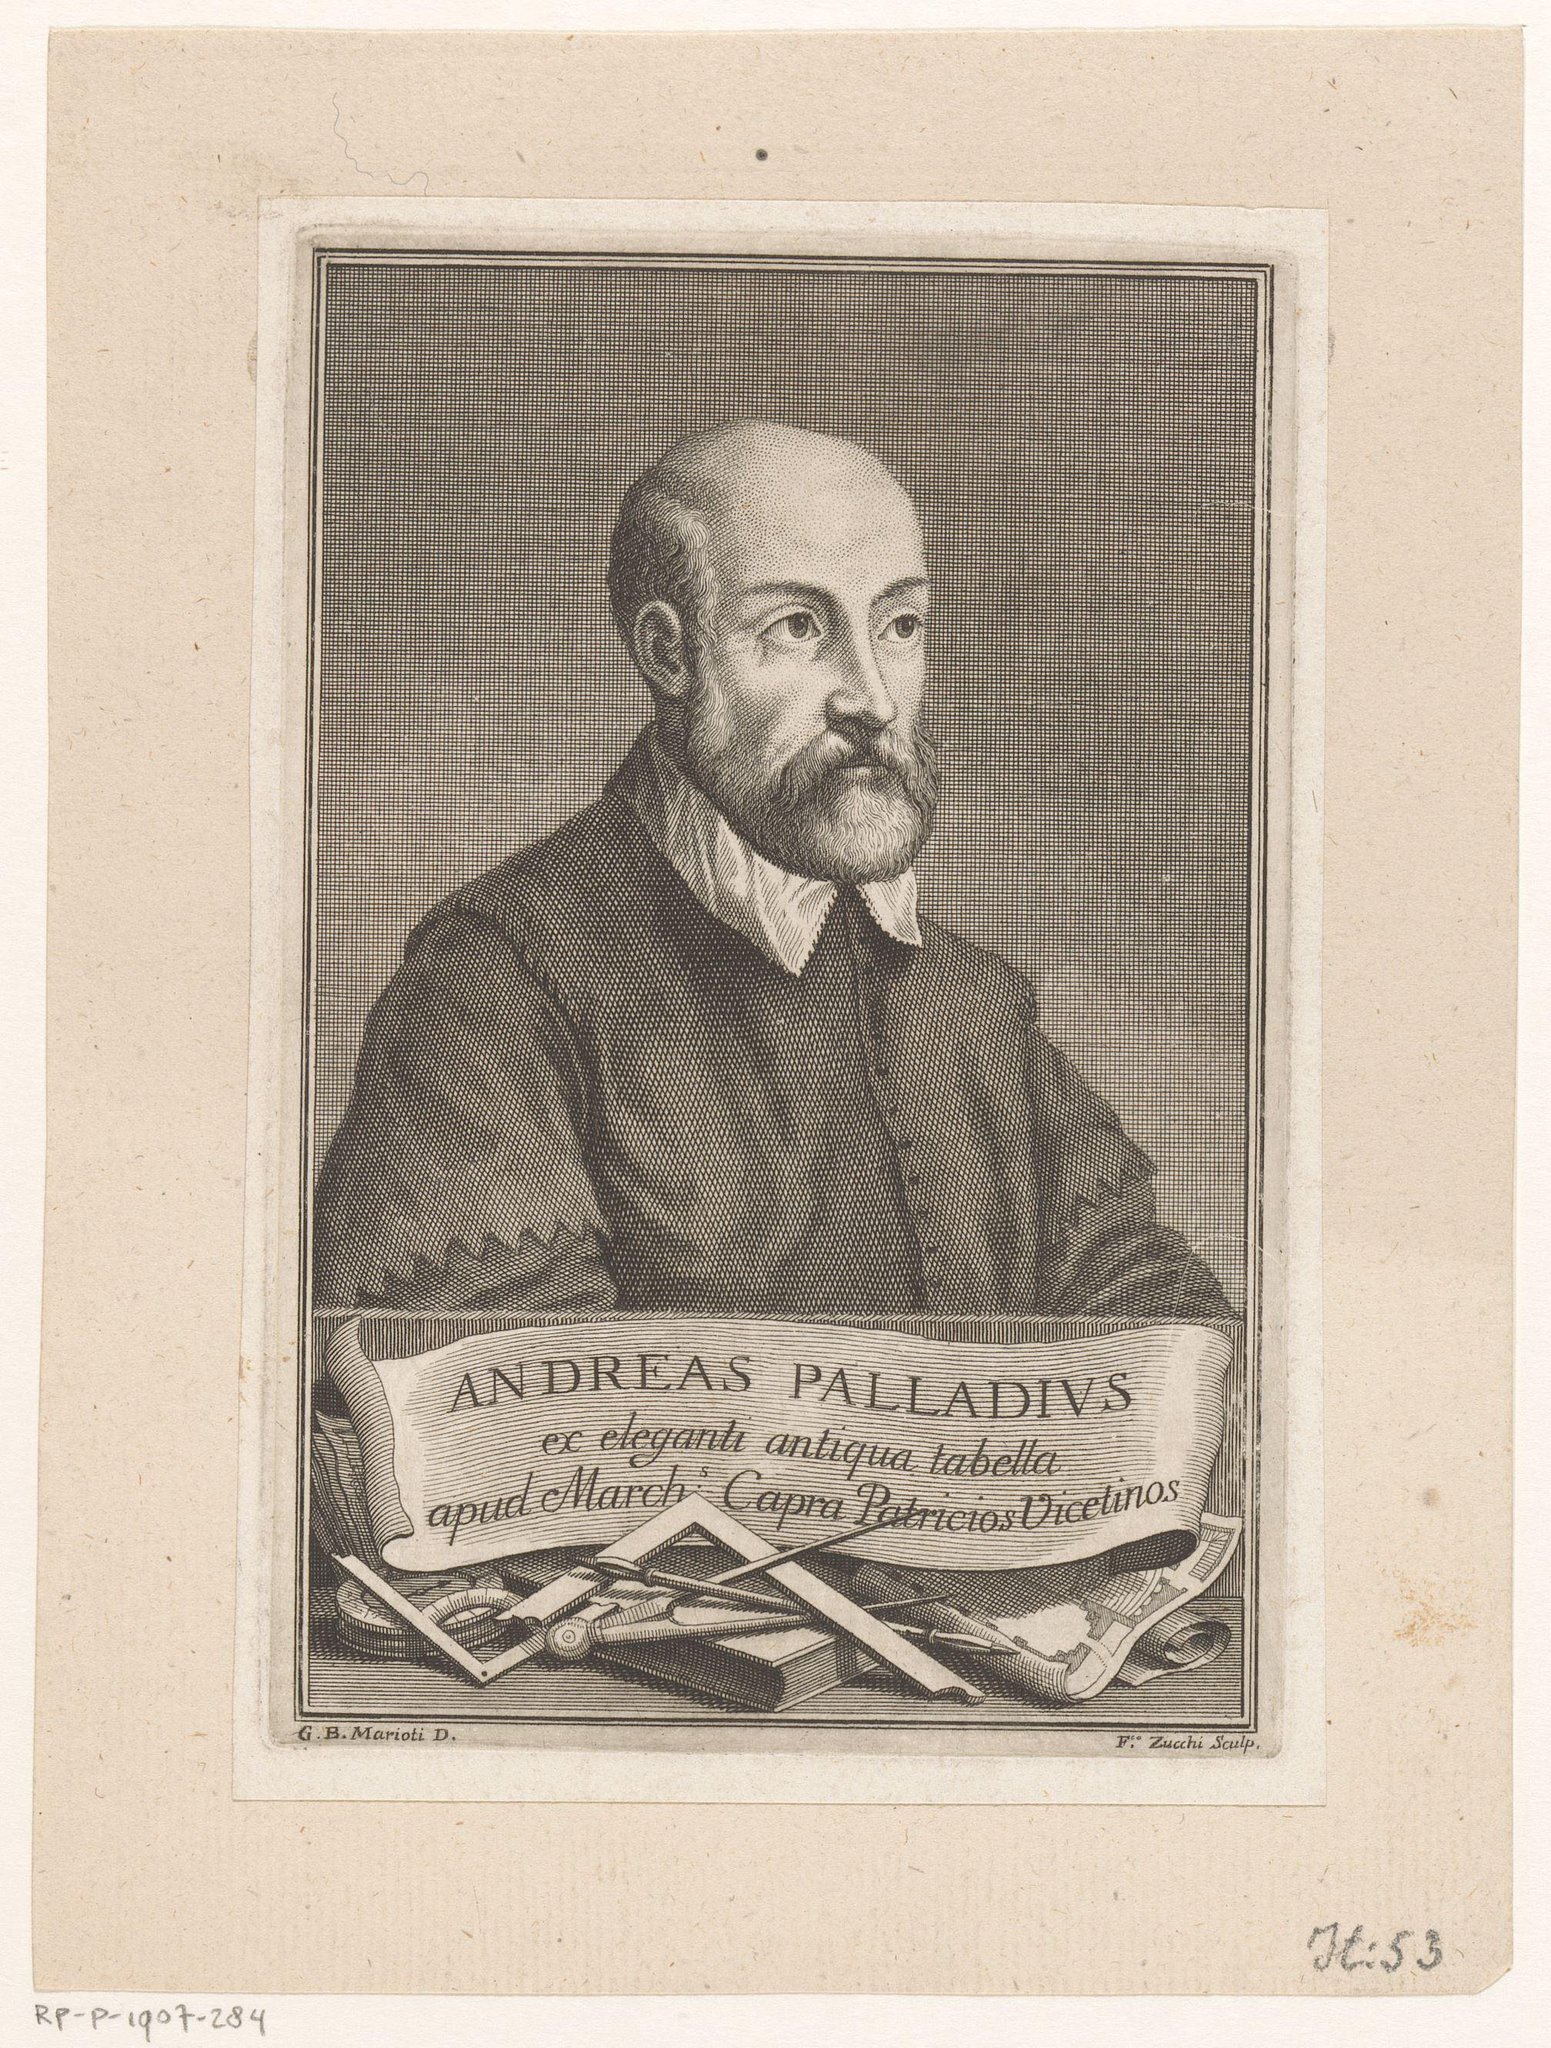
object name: print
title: Portret van architect Andrea Palladio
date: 1702-1764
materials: paper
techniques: engraving, etching, intaglio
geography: italy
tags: andrea palladio, historical persons, portrait, self-portrait of architect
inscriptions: collector's mark: Lugt 2228